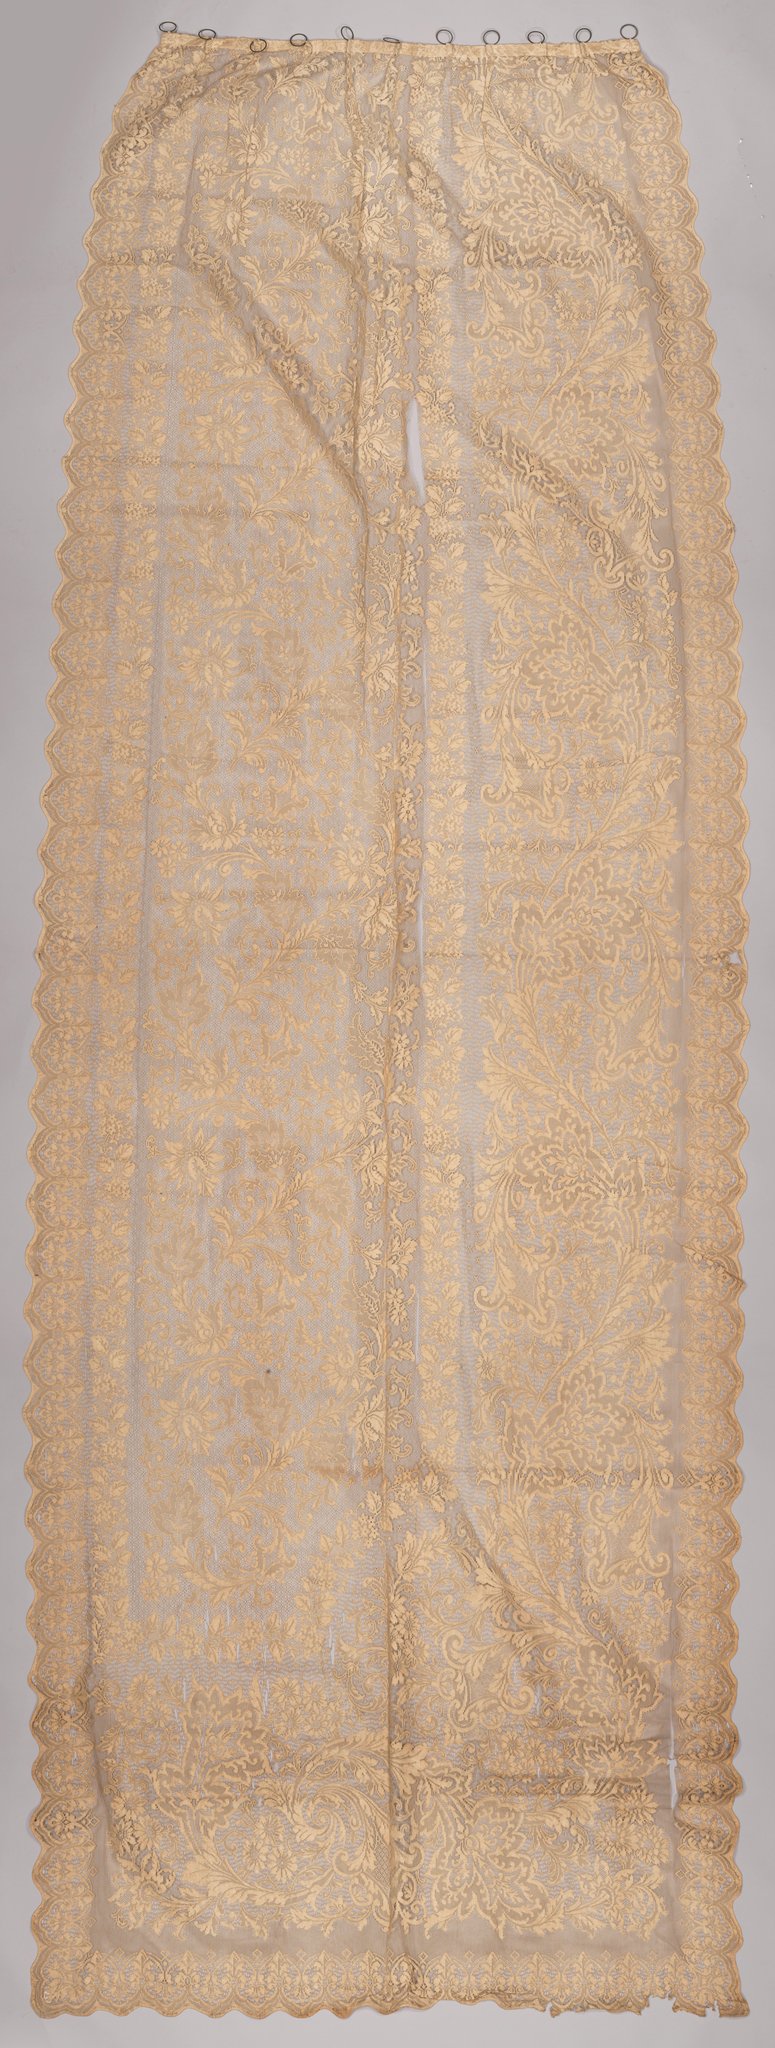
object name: curtain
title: Vitrage van machinale kant met opgaande bloem- en bladranken binnen drie schulpranden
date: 1890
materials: lace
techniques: lace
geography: plauen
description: Vitrage van machinale kant. Het patroon heeft opgaande bloem- en bladranken binnen drie schulpranden. De vitrage heeft aangenaaide ringen.